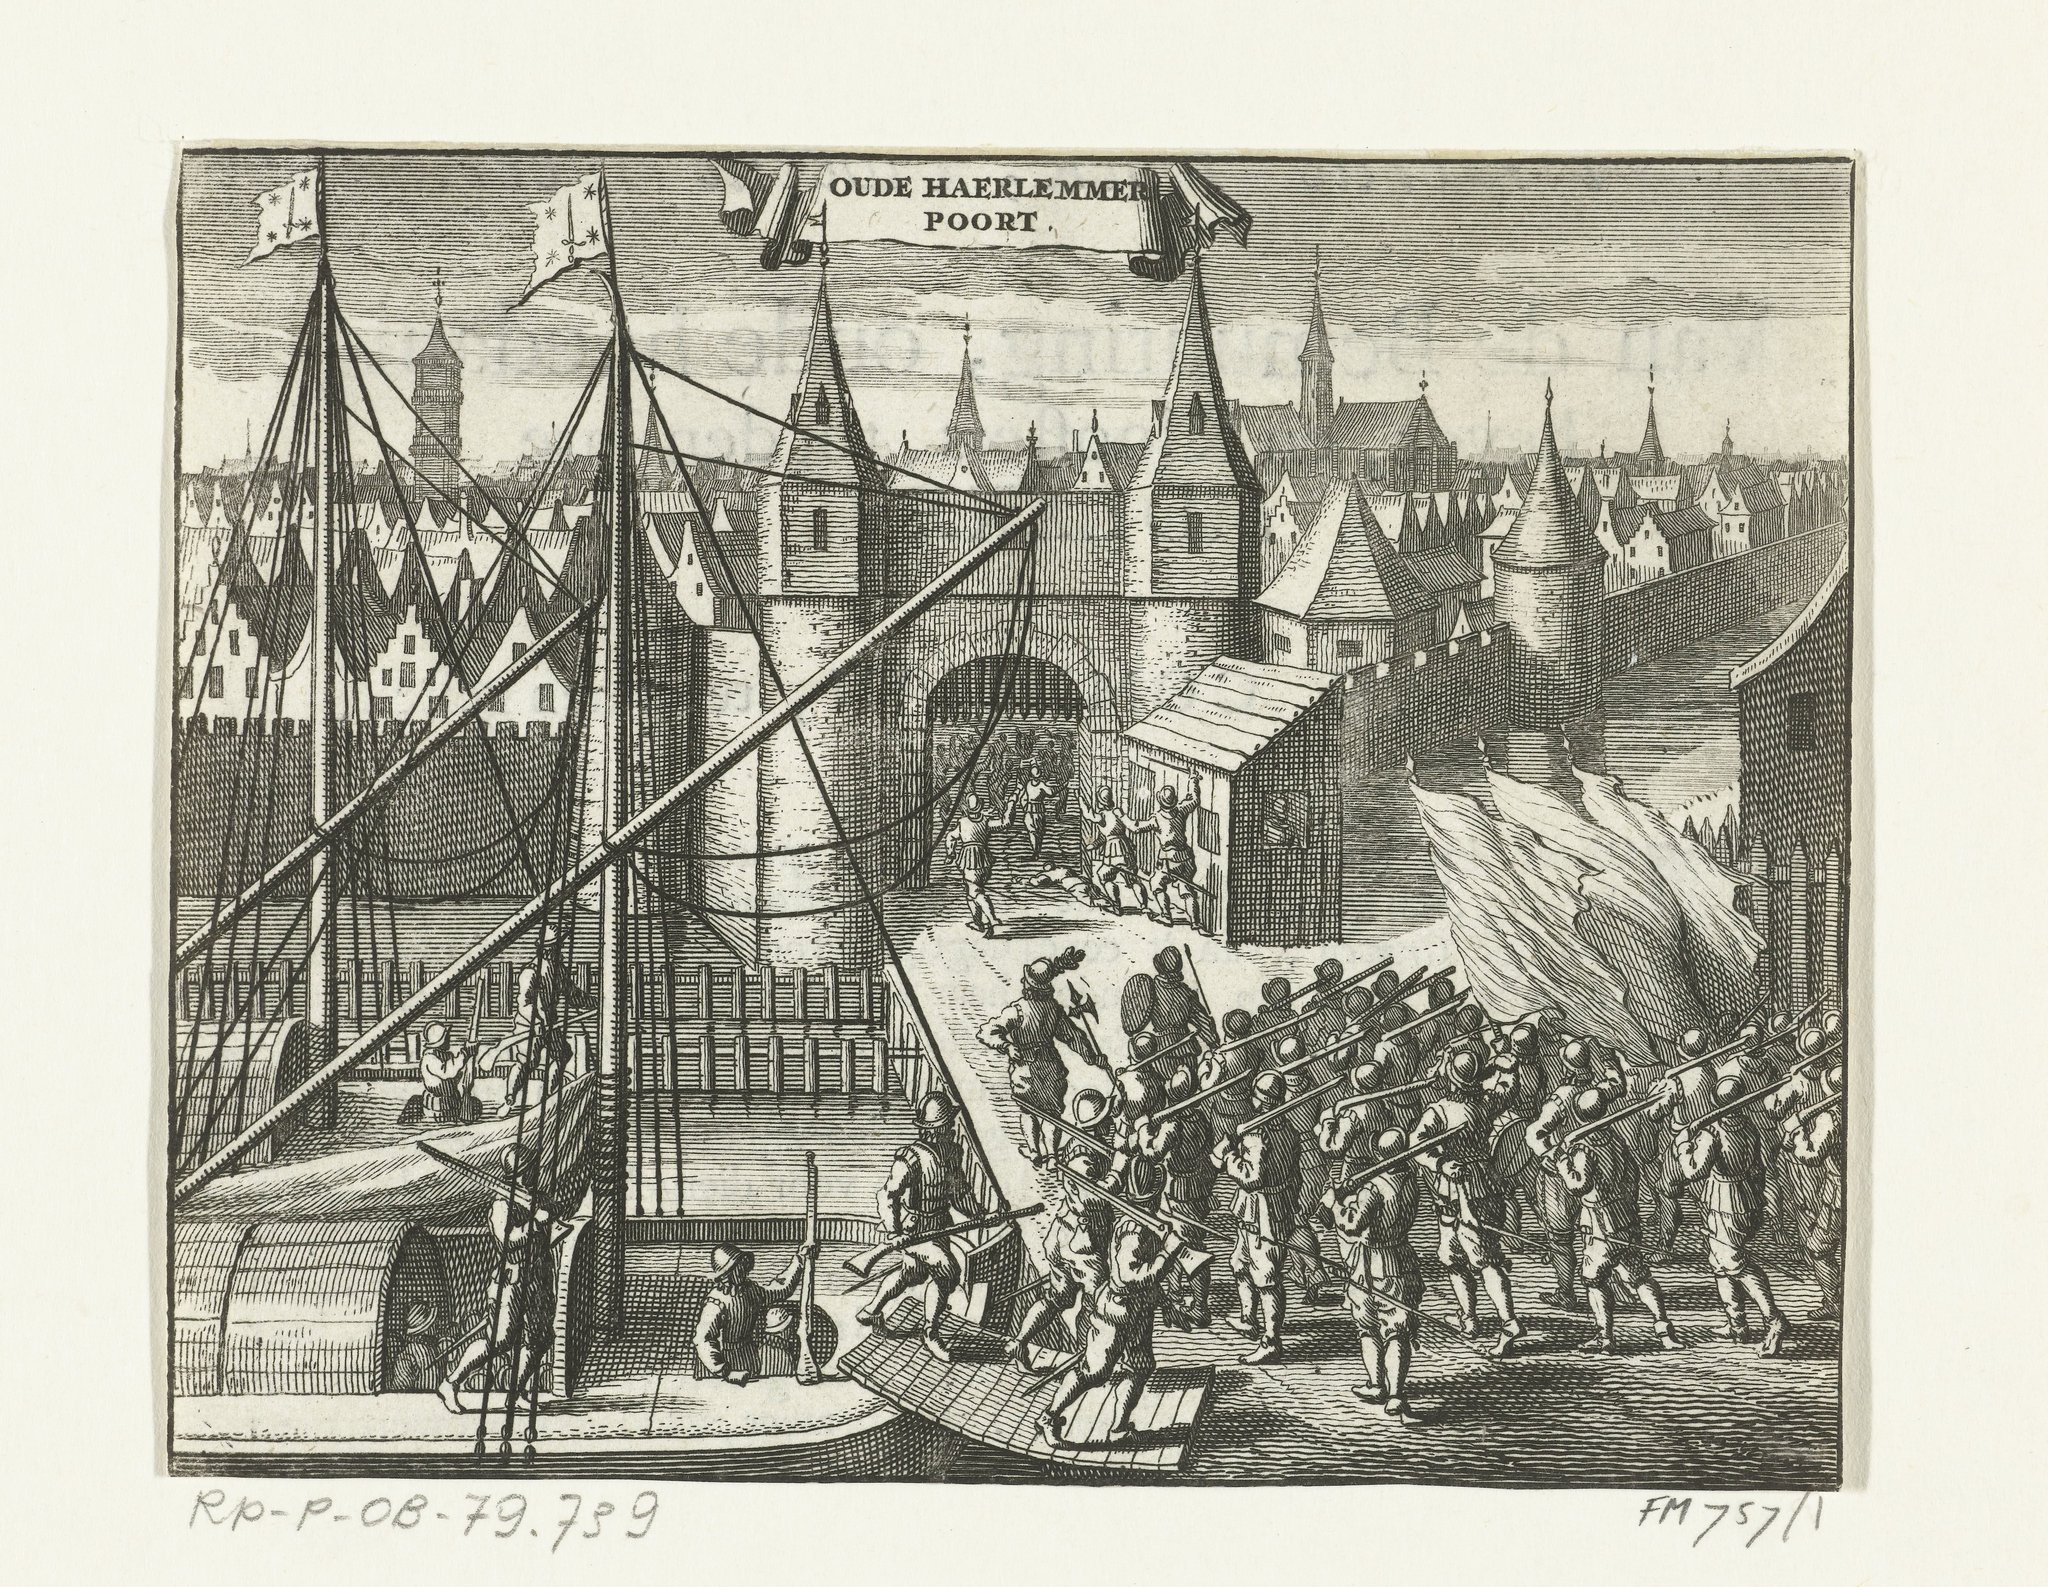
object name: history print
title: Poging om Amsterdam in te nemen, 1577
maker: Anonymous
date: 1693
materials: paper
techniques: engraving, etching, letterpress printing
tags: amsterdam, haarlem, battle, city-gate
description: Huidige staat van prent gebruikt in: Commelin, Caspar. Beschryvinge van Amsterdam, zynde een naukeurige verhandelinge van desselfs eerste oorspronk uyt (…). 2 delen. 2e druk. Amsterdam: Andries van Damme, Johannes Ratelband, weduwe A. van Aaltwyk en Hermanus Uytwerf, 1726. Eerdere staat van prent ook gebruikt in: Commelin, Caspar. Beschryvinge van Amsterdam, desselfs eerste oorspronk uyt den Huyse (…). 2 delen. Amsterdam: Abraham Wolfgang, Gillis Janssonius van Waesberge, Johannes Janssonius van Waesberge II, weduwe Dirk Boom I, Hendrick Boom en Rembertus Goethals, 1693. En in: Commelin, Caspar. Beschryvinge van Amsterdam, zynde een naukeurige verhandelinge van desselfs eerste oorspronk uyt (…). 2 delen. Amsterdam: weduwe Aart Dircksz Oossaan, 1694.